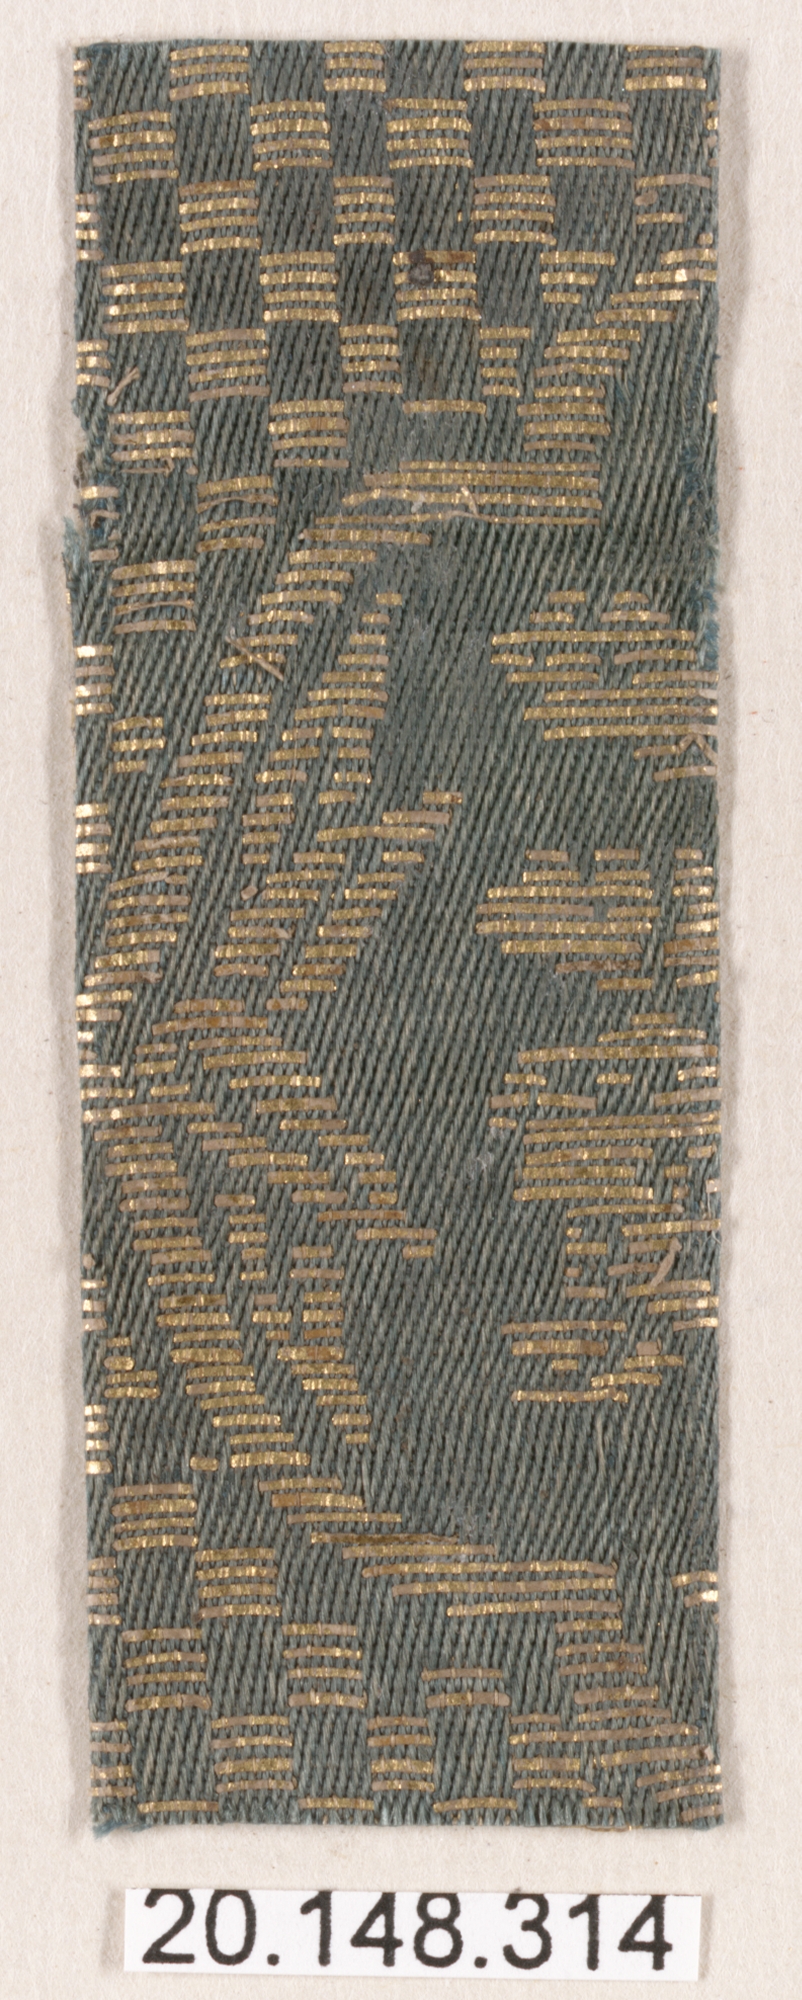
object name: piece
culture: japanese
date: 1601-1700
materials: silk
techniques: compound weave